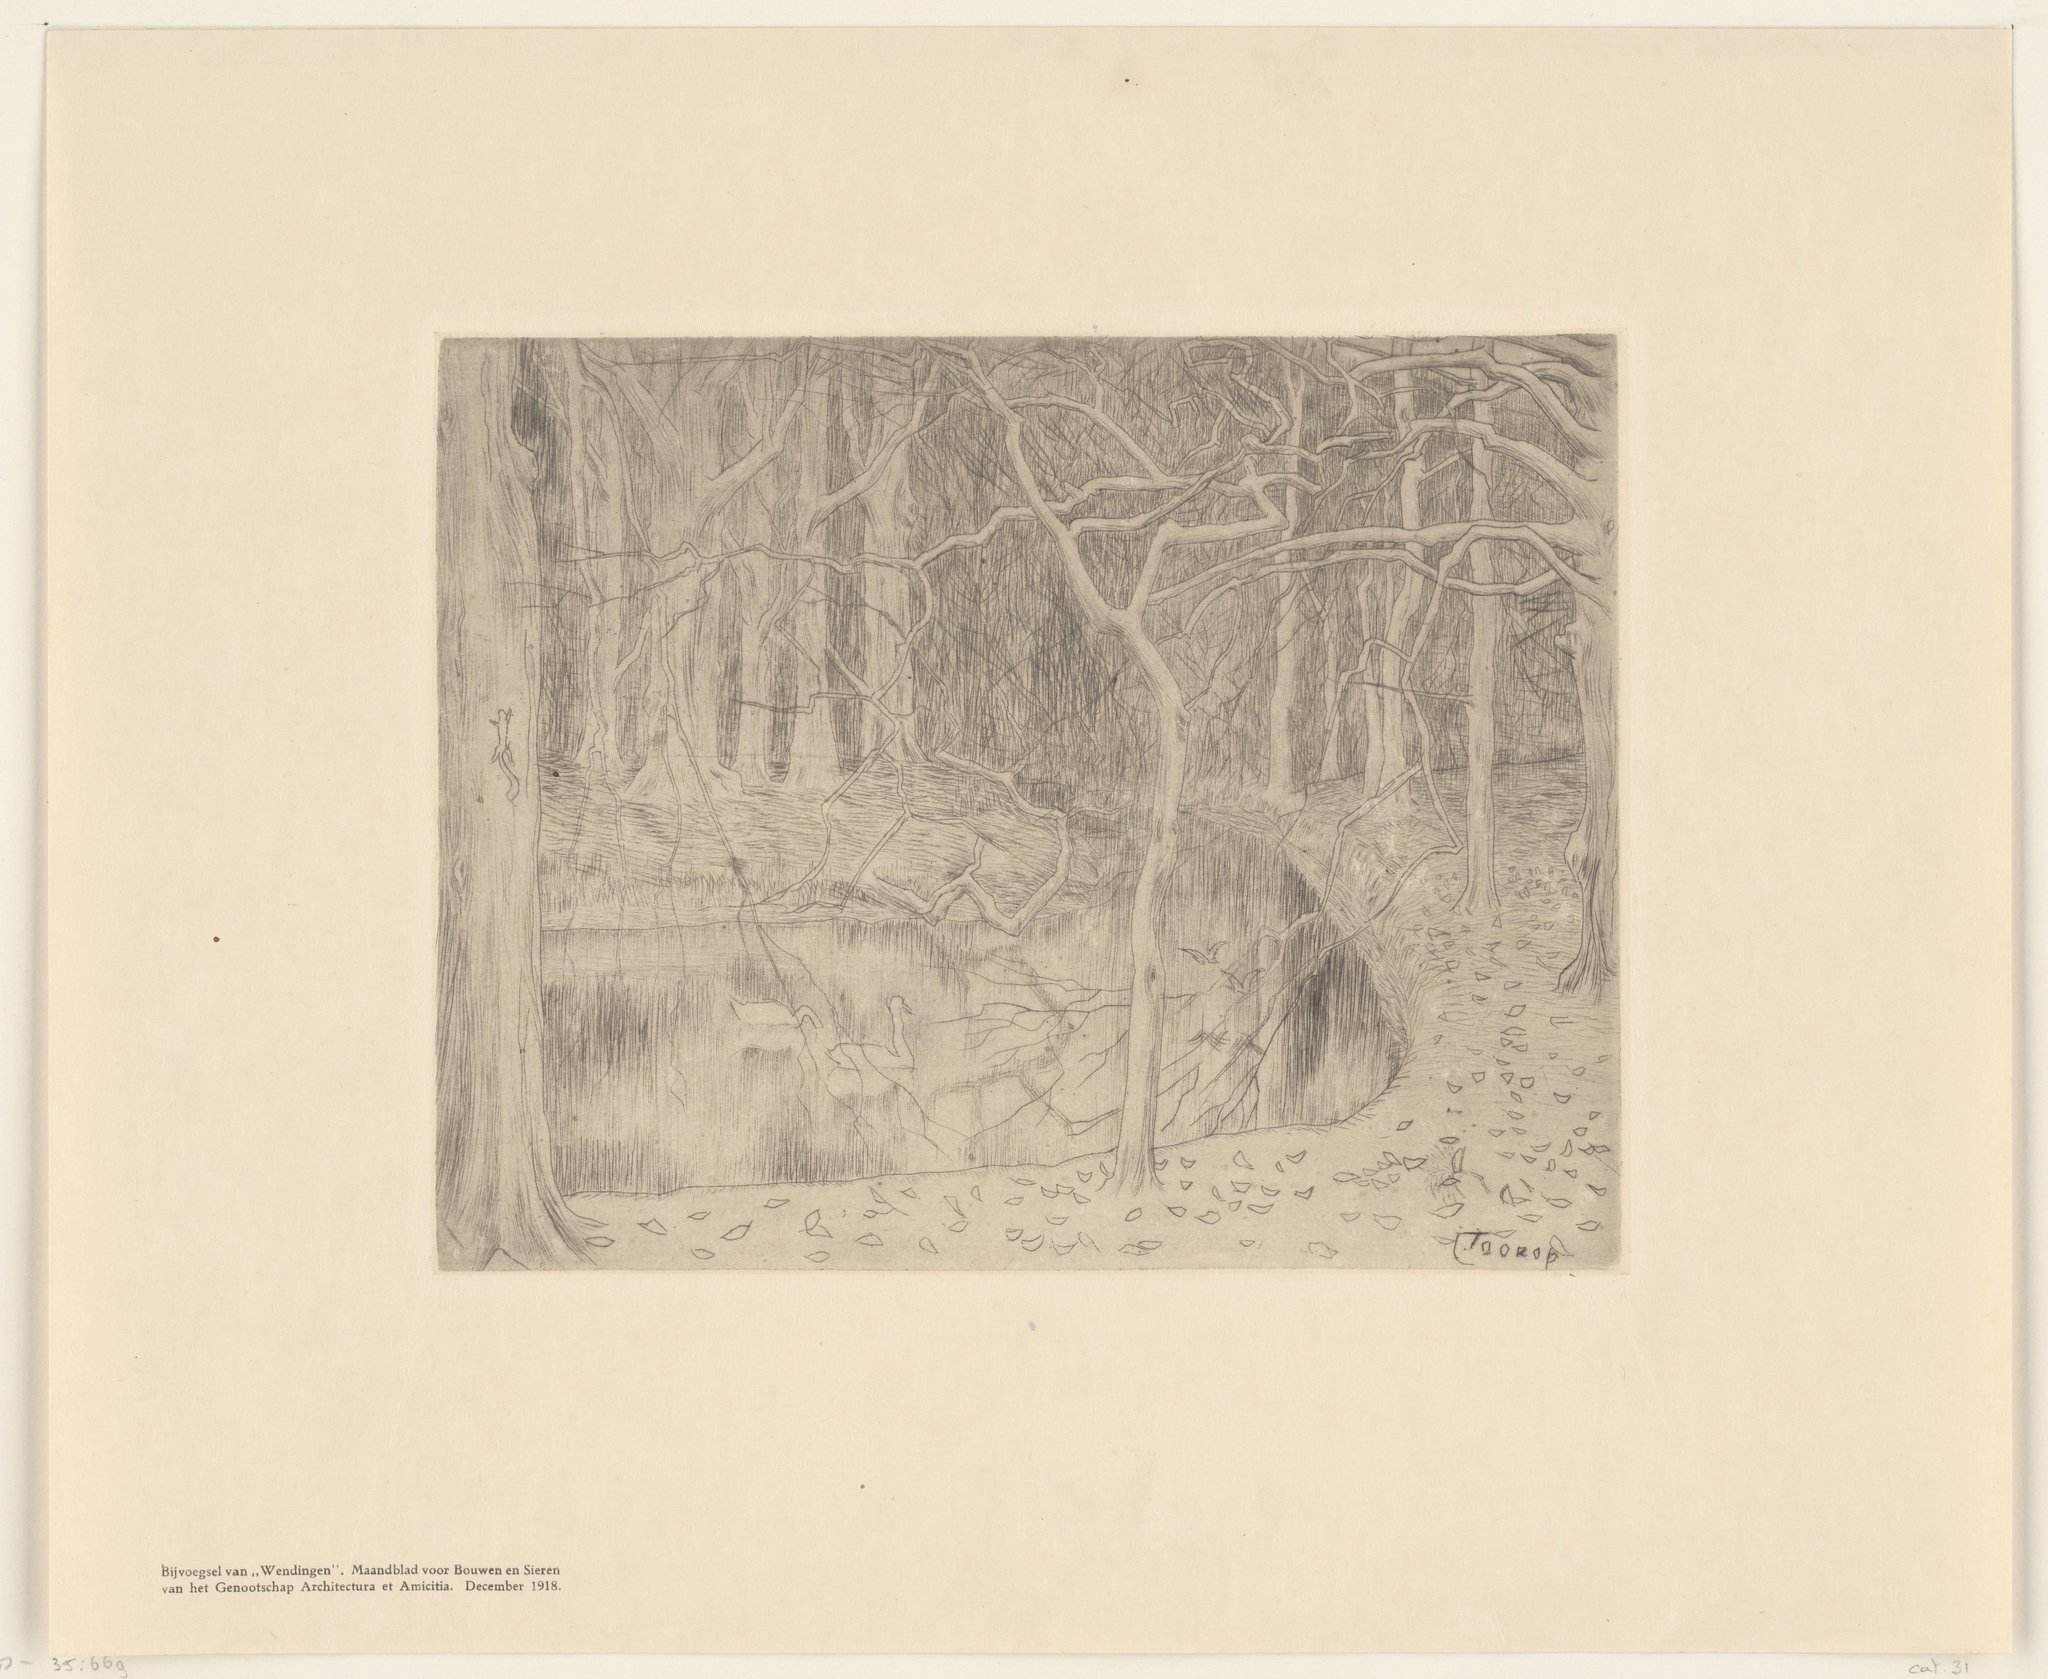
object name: print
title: Bos met vijver en zwanen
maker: jan toorop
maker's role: draughtsman, painter, print maker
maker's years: 1858-1928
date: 1895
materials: paper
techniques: drypoint, intaglio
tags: water-birds: swan, forest, wood, pond, pool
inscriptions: inscription: ‘Bijvoegsel van "Wendingen". Maandblad voor Bouwen en Sieren/ van het Genootschap Architectura et Amicitia. December 1918’, collector's mark: Lugt 2760, collector's mark: Lugt 2228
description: Op de prent zou het bos 'De Manteling', bij Domburg, zijn afgebeeld. Mogelijk op het landgoed van Kasteel Westhove. Deze prent is verschenen als bijvoegsel van: Wendingen. Maandblad voor bouwen en sieren van "Architectura et Amicitia". Amsterdam: De Hooge Brug 1918, 11-12.